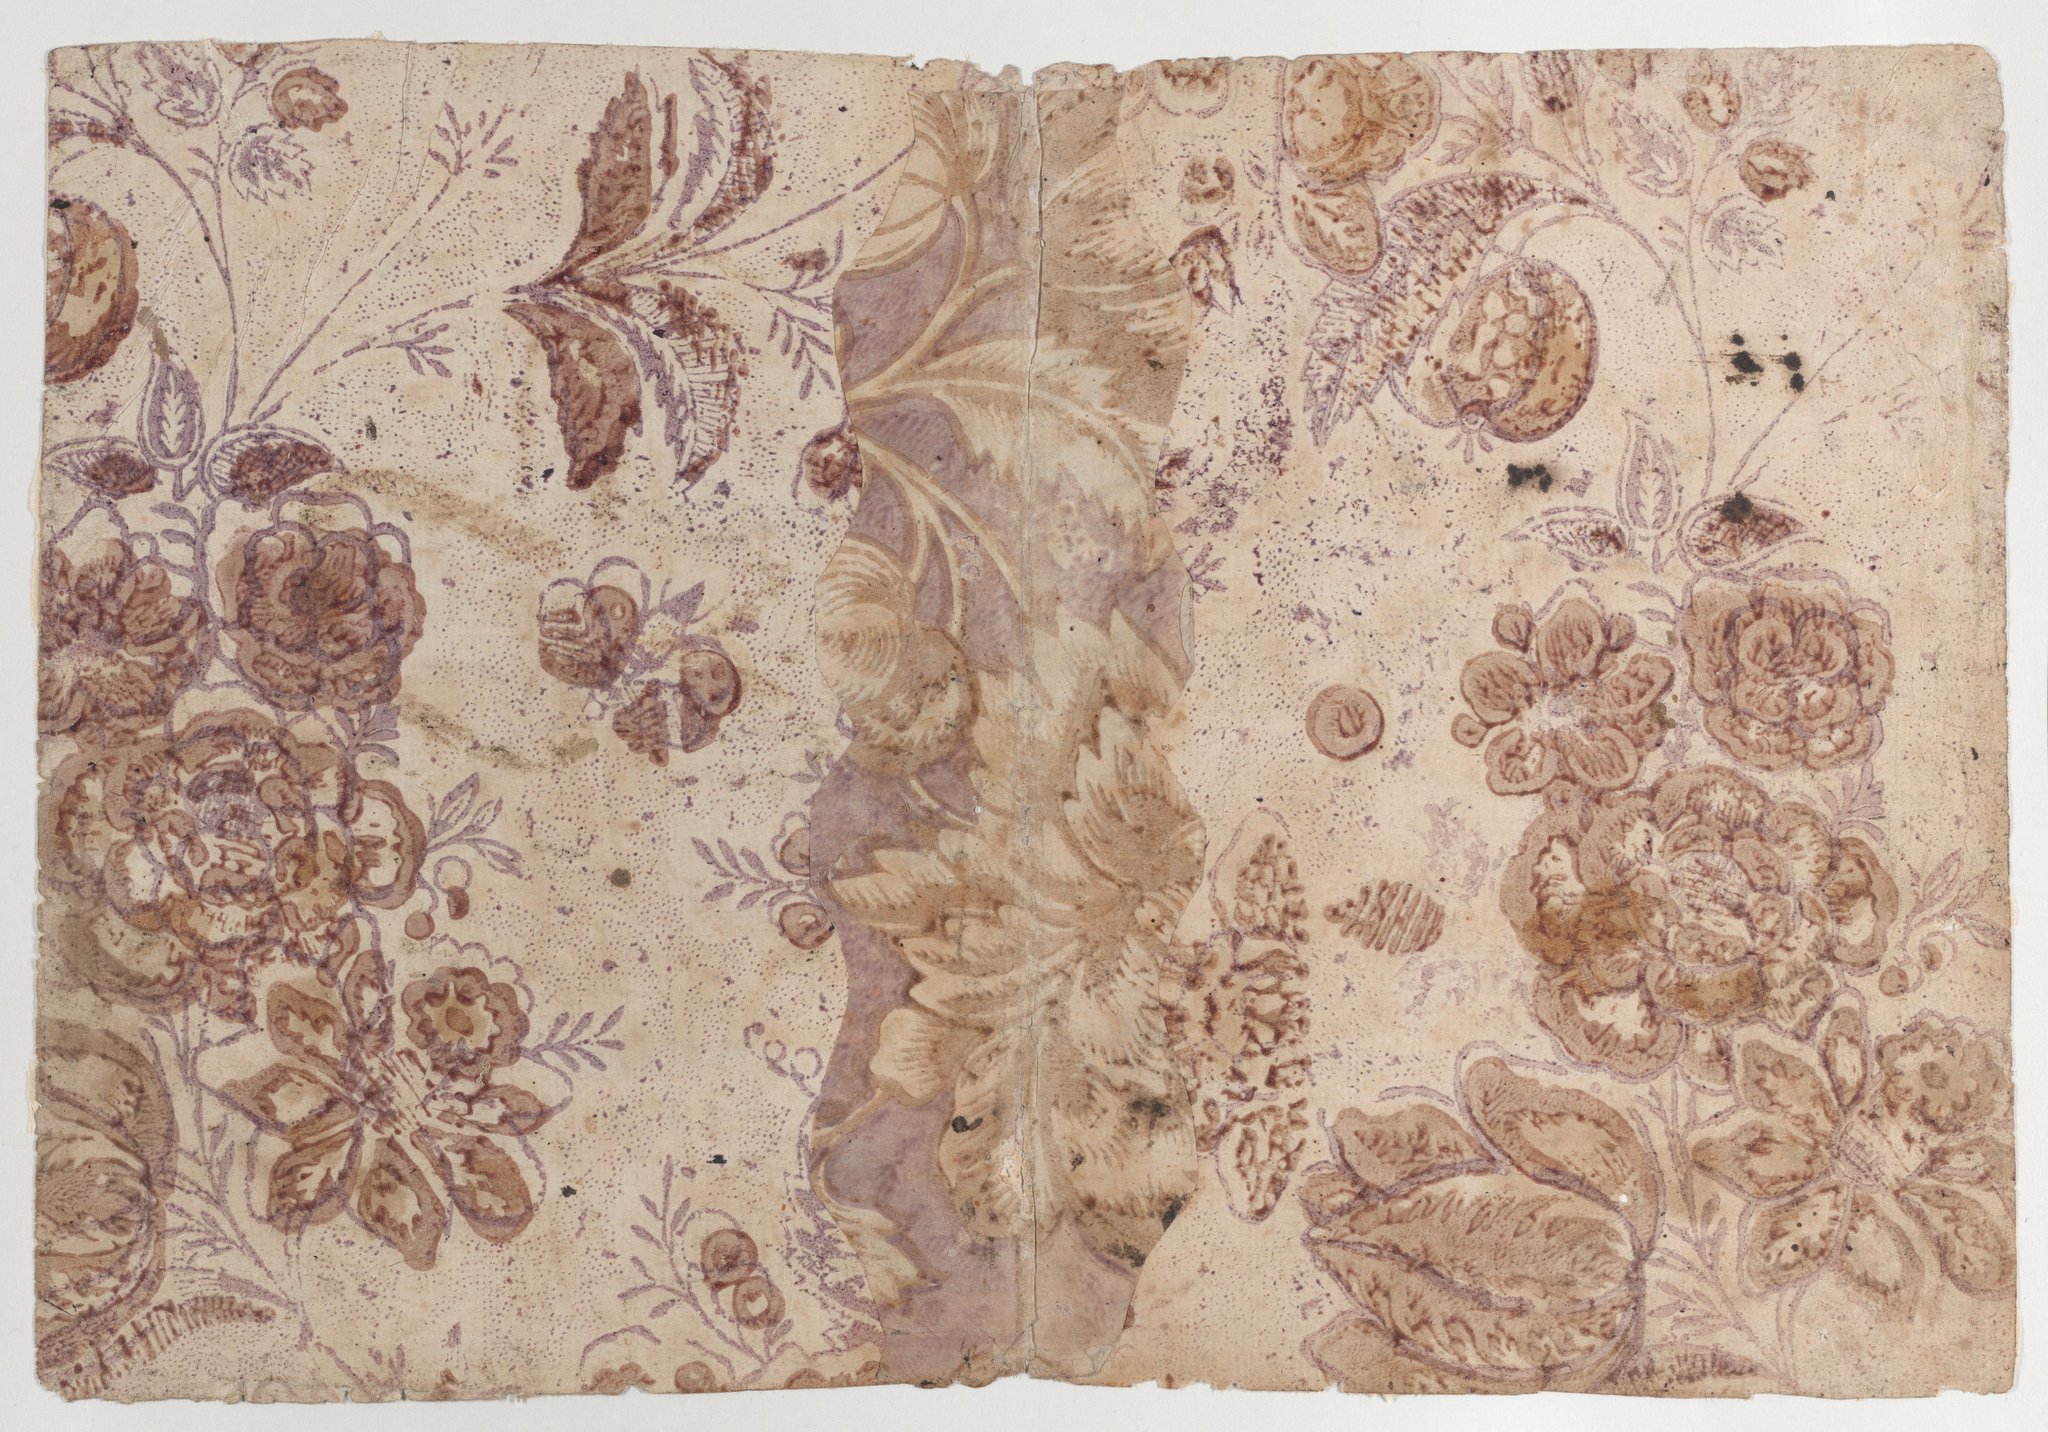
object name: print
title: Book cover with overall floral and dot pattern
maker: Anonymous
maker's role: artist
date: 1701-1800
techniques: relief print